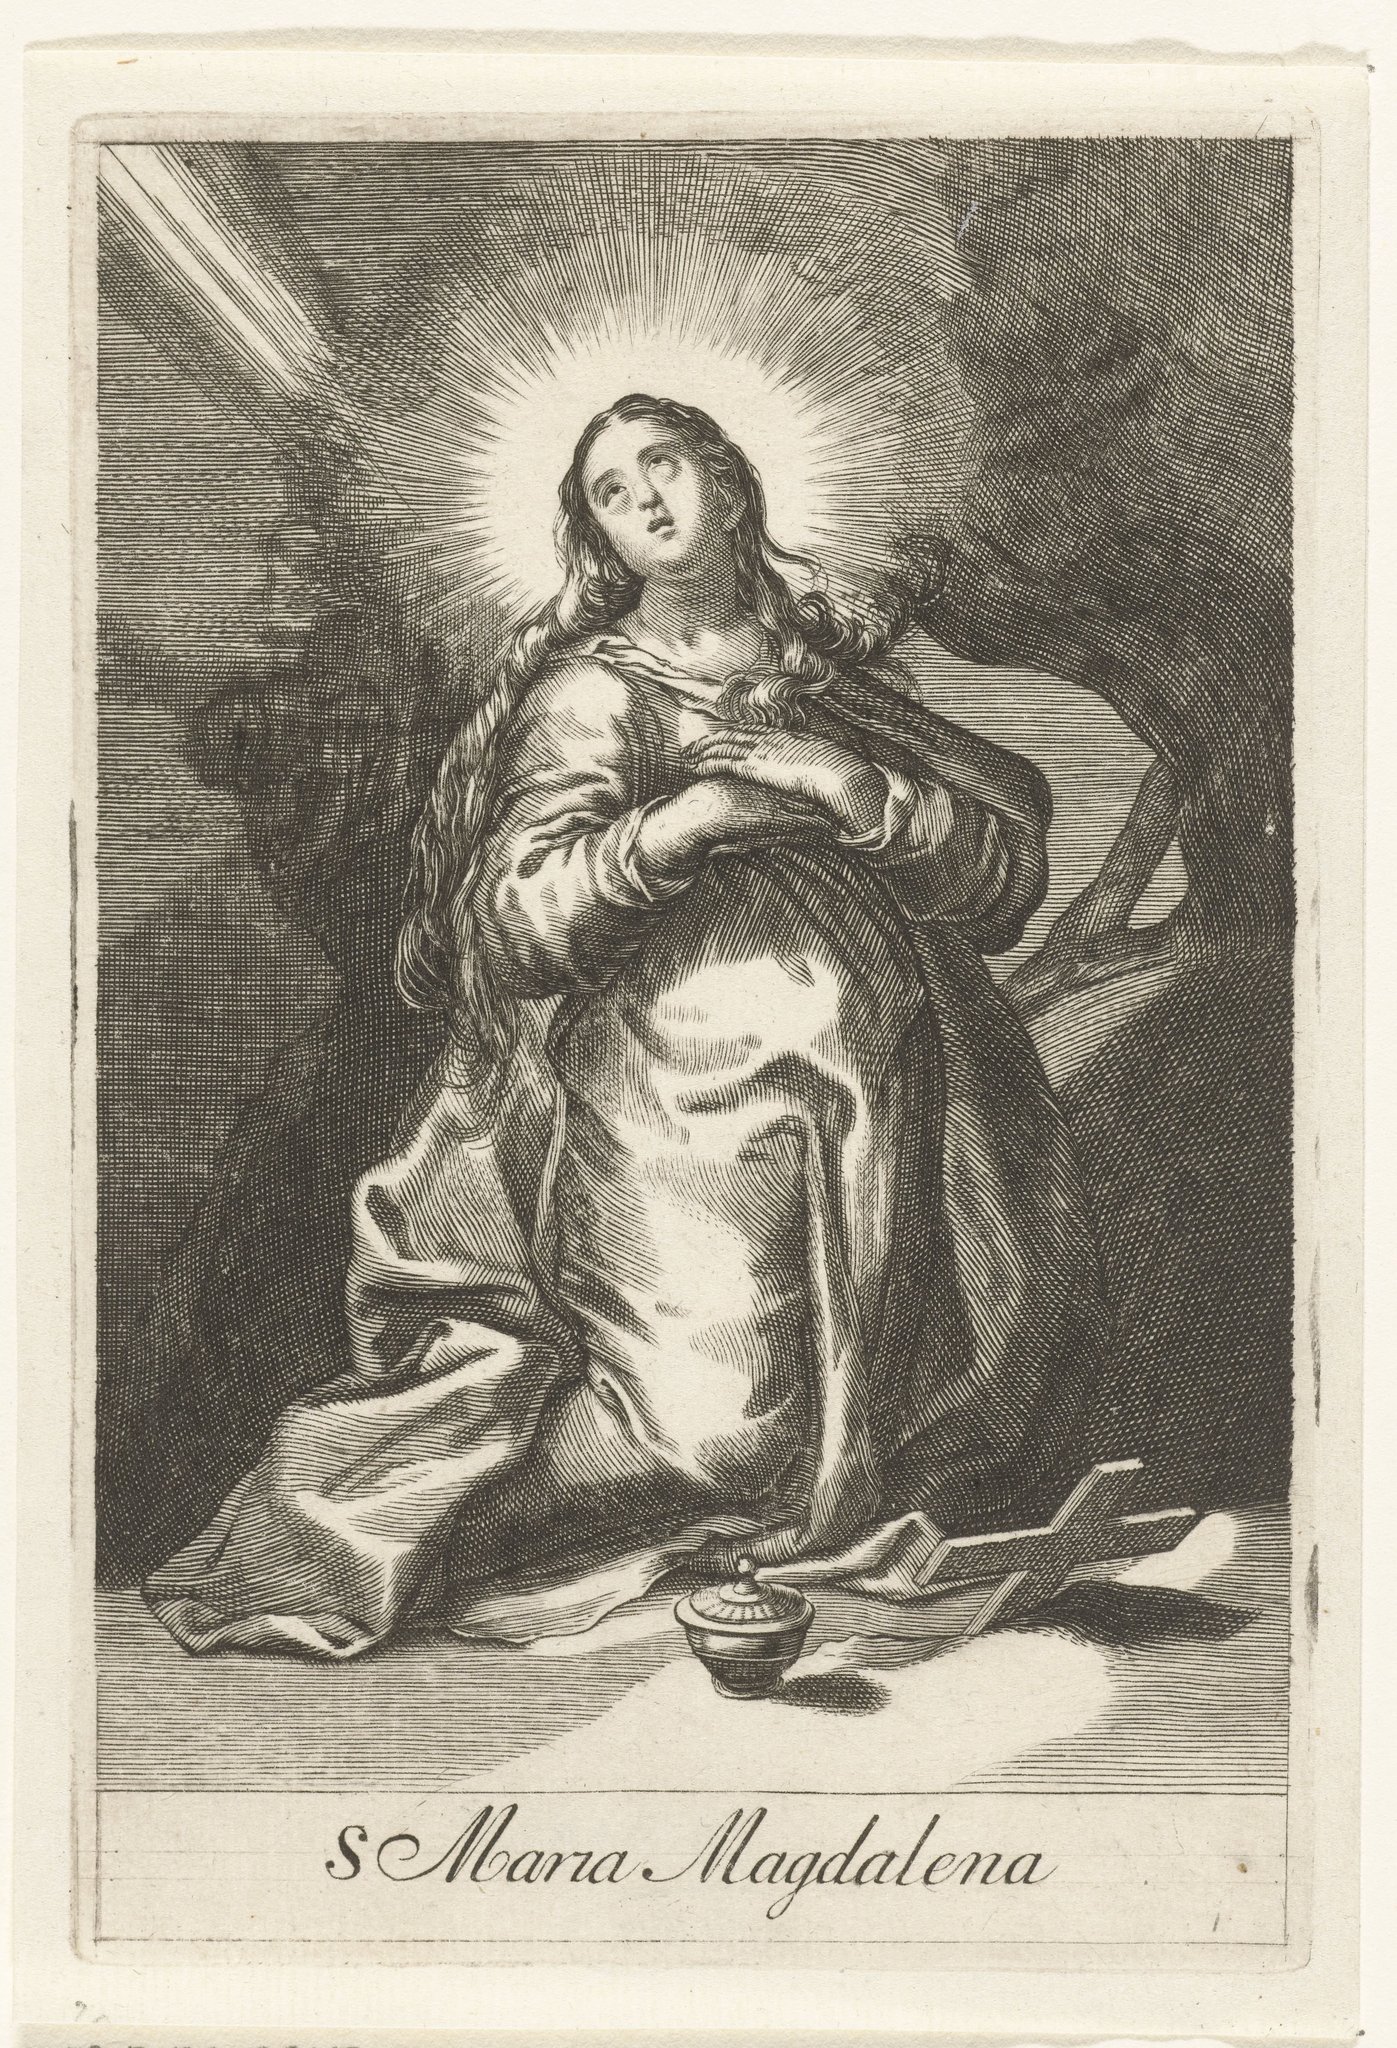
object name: print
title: Sacra Eremus Ascetriarum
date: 1590-1662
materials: paper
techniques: engraving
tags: anchorite, hermit, the penitent harlot mary magdalene; possible attributes: book (or scroll), crown, crown of thorns, crucifix, jar of ointment, mirror, musical instrument, palm-branch, rosary, scourge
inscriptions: collector's mark: Lugt 2228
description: Kopie in spiegelbeeld naar prent van Boëtius Adamsz. Bolswert.